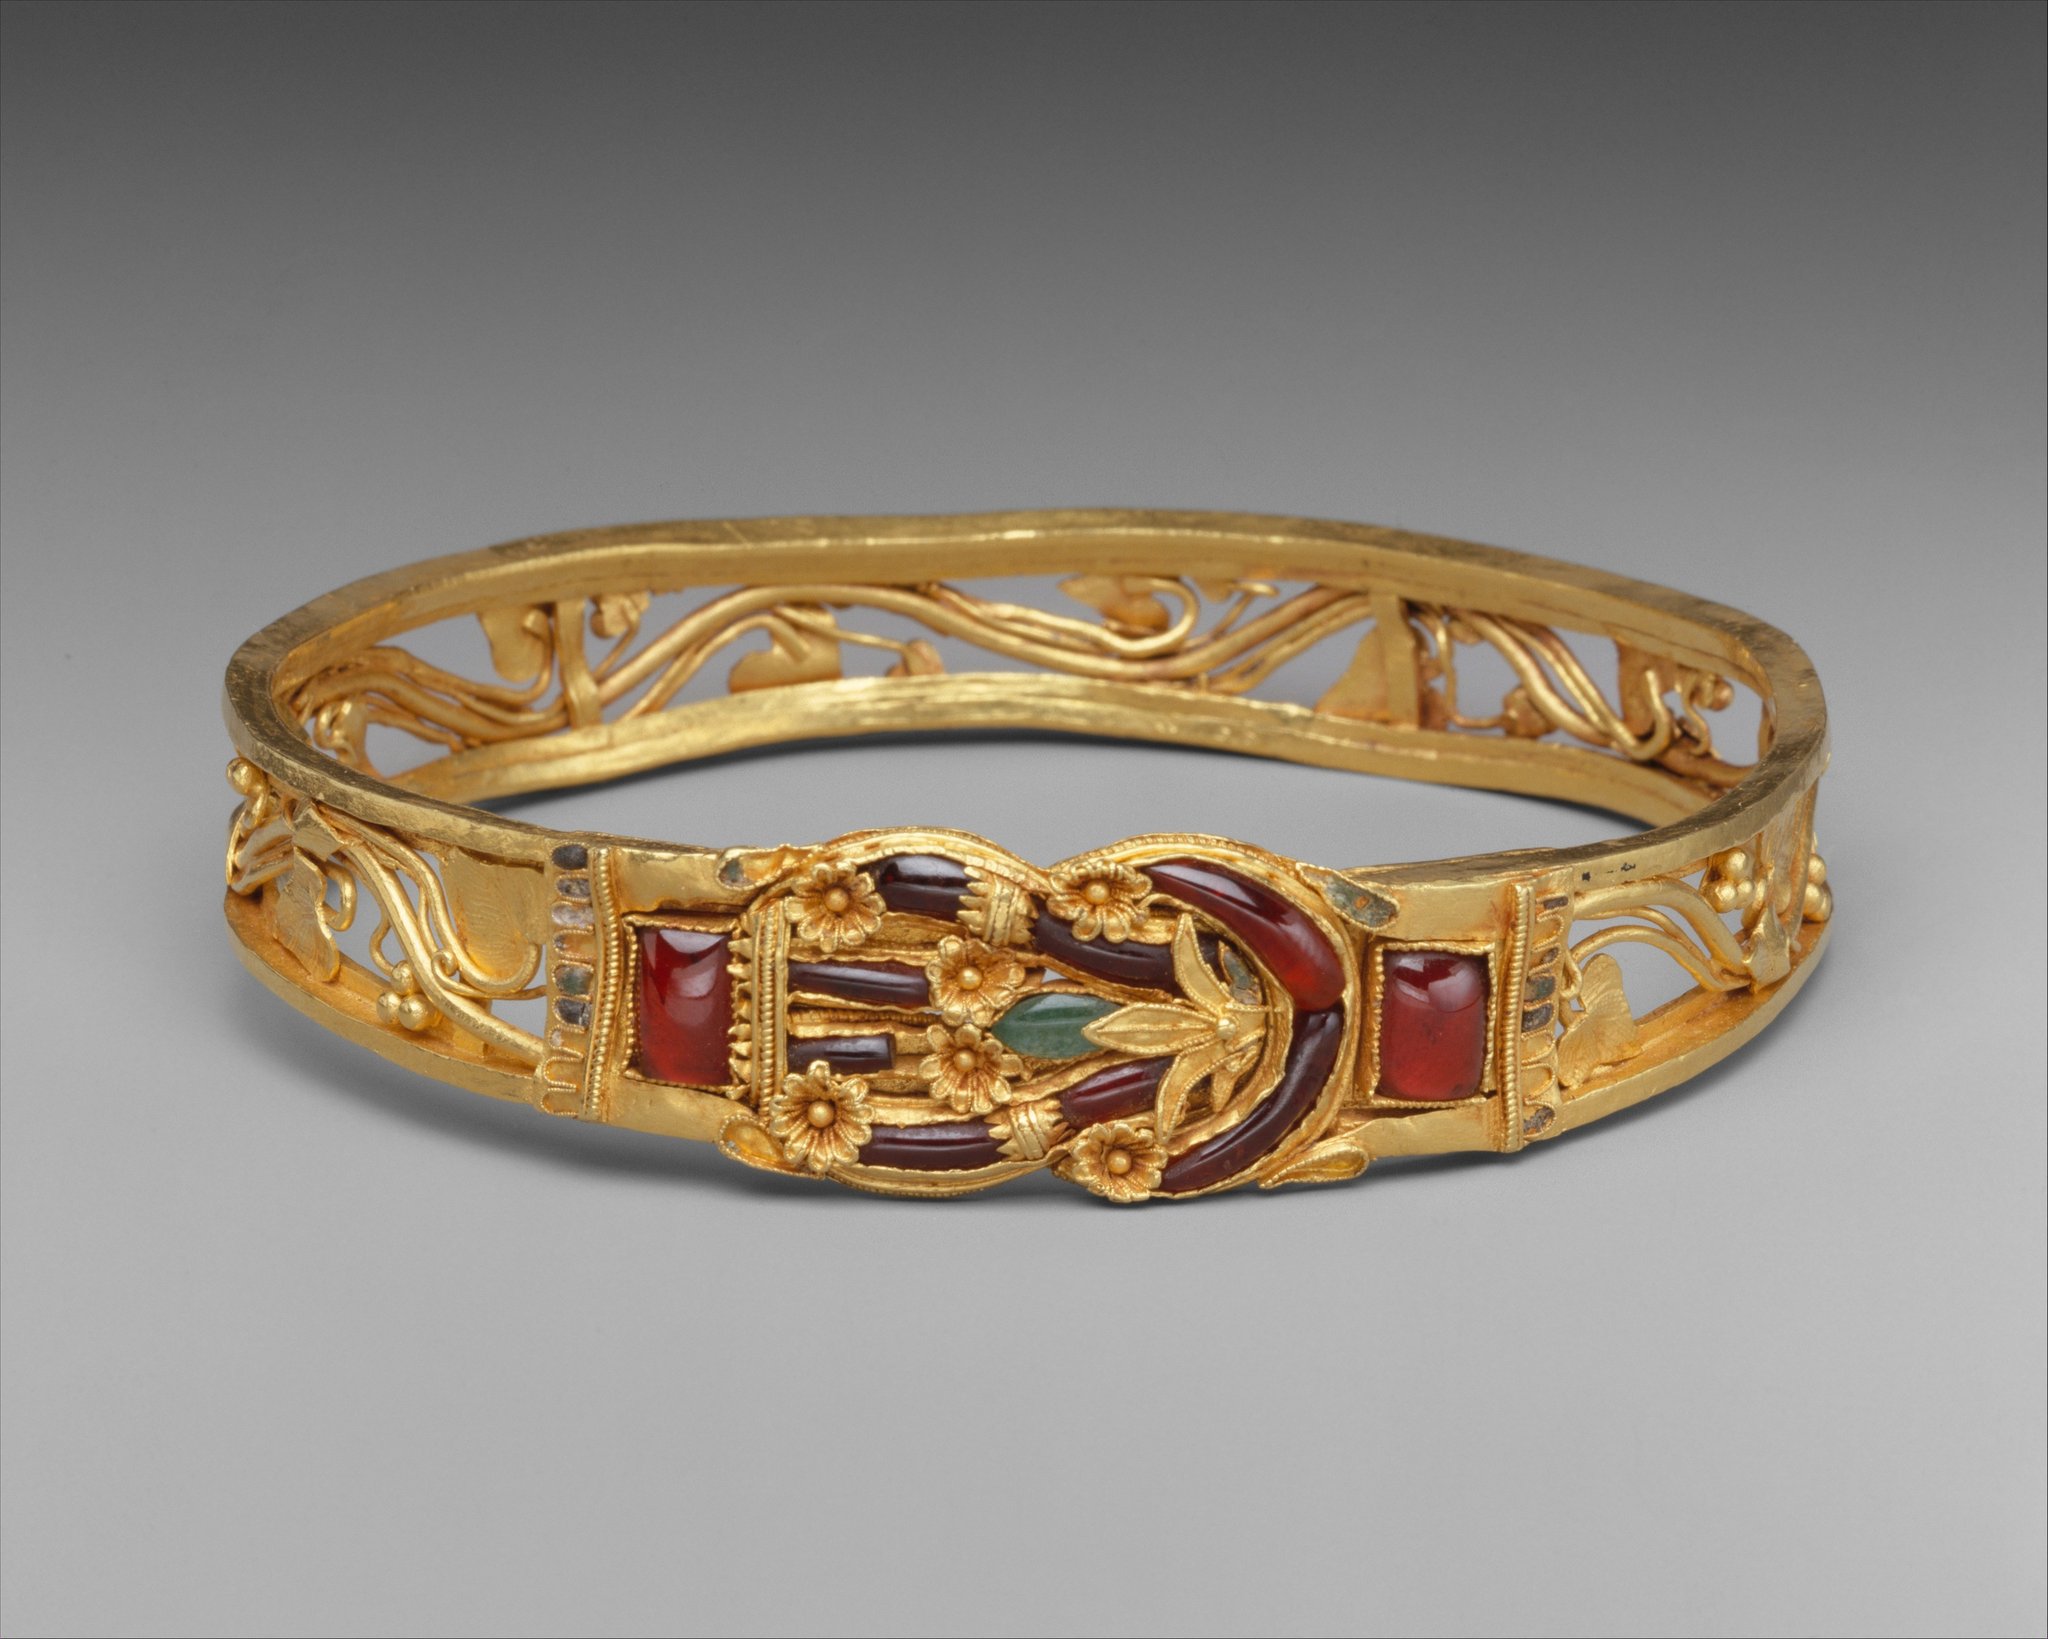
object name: armband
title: Gold armband with Herakles knot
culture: greek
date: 300-101 BCE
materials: gemstone, enamel, garnet, gold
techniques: inlay